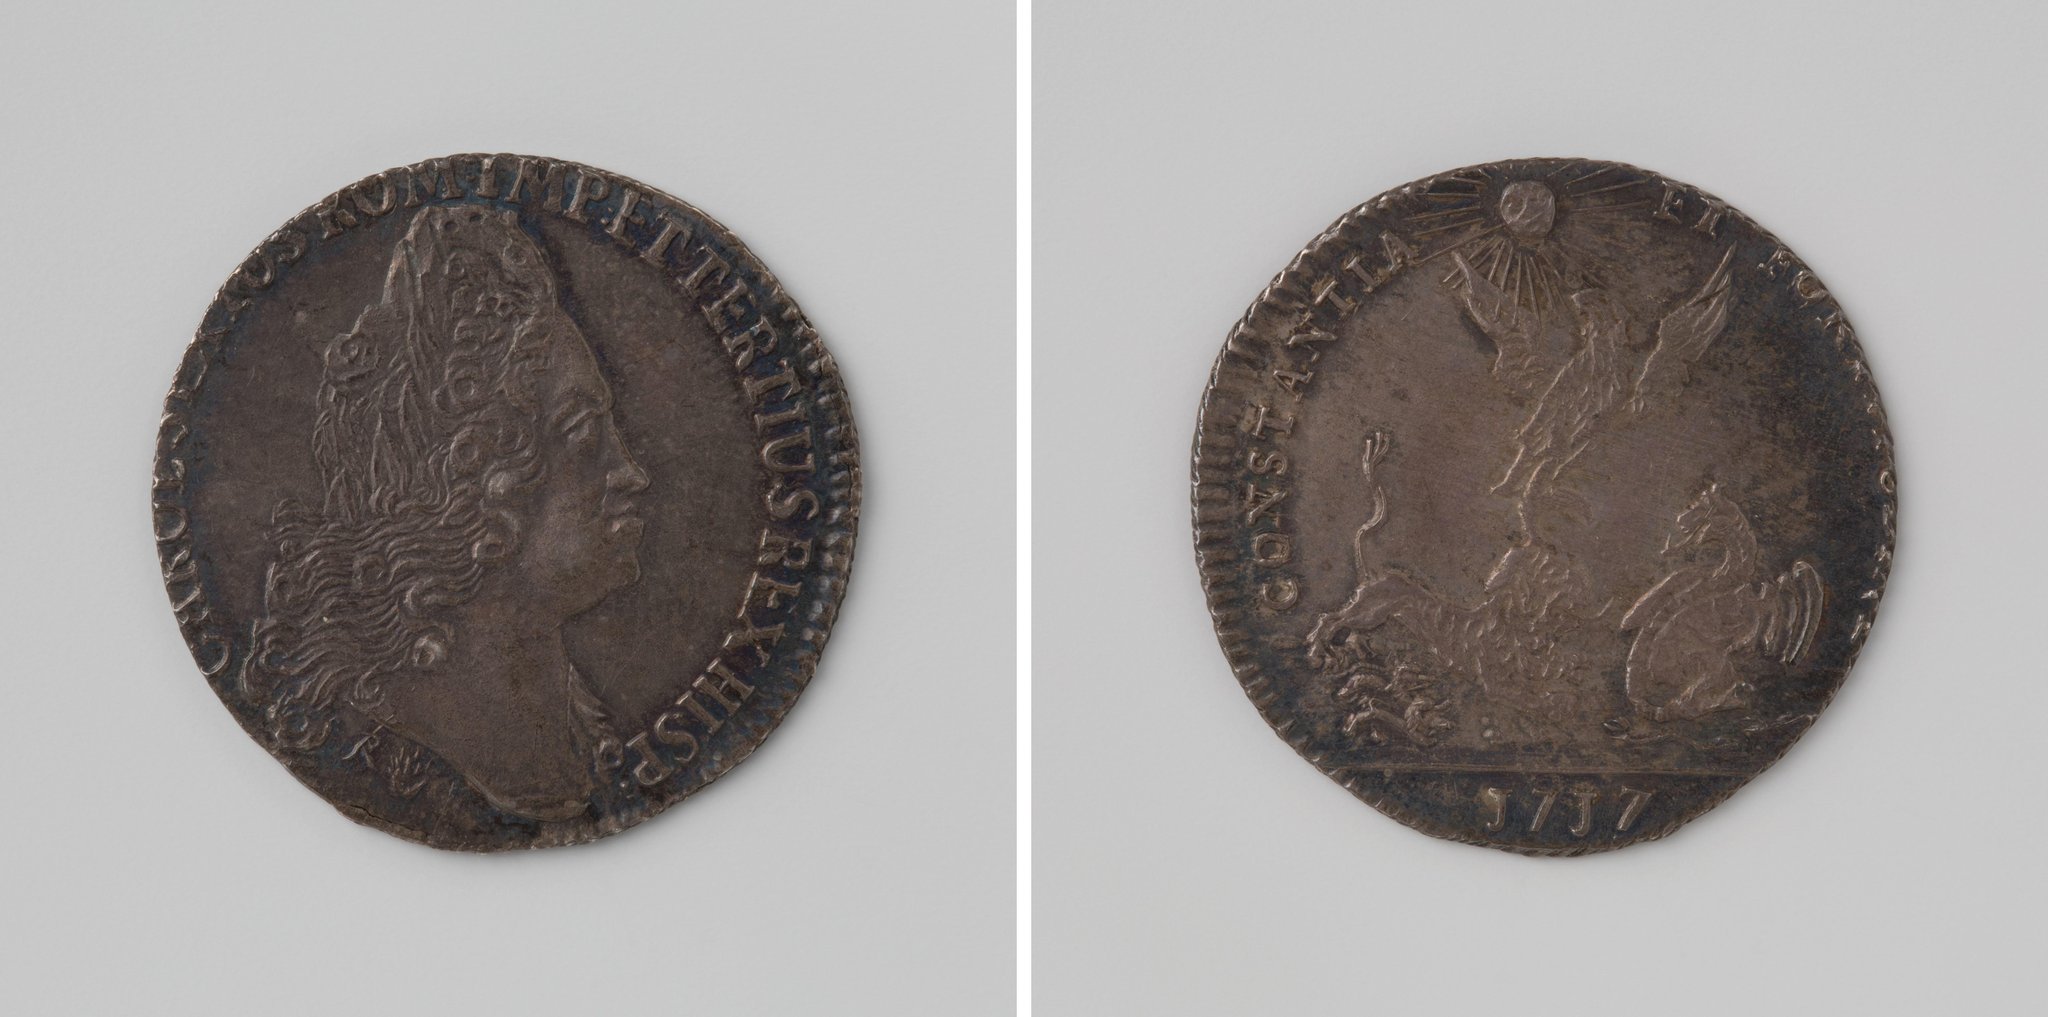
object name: jeton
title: Overwinning van Karel VI op de Turken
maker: philippe roëttiers (ii)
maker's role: medailleur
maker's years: 1640-1718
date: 1717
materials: silver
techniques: striking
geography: antwerp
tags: vienna, charles vi (holy roman emperor)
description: Zilveren penning. Voorzijde: borststuk man met lauwerkrans binnen omschrift. Keerzijde: arend met halve maan in klauwen vliegt op naar stralende zon, daaronder leeuwin met twee jongen jaagt draak en twee slangen op vlucht binnen omschrift; afsnede: jaartal